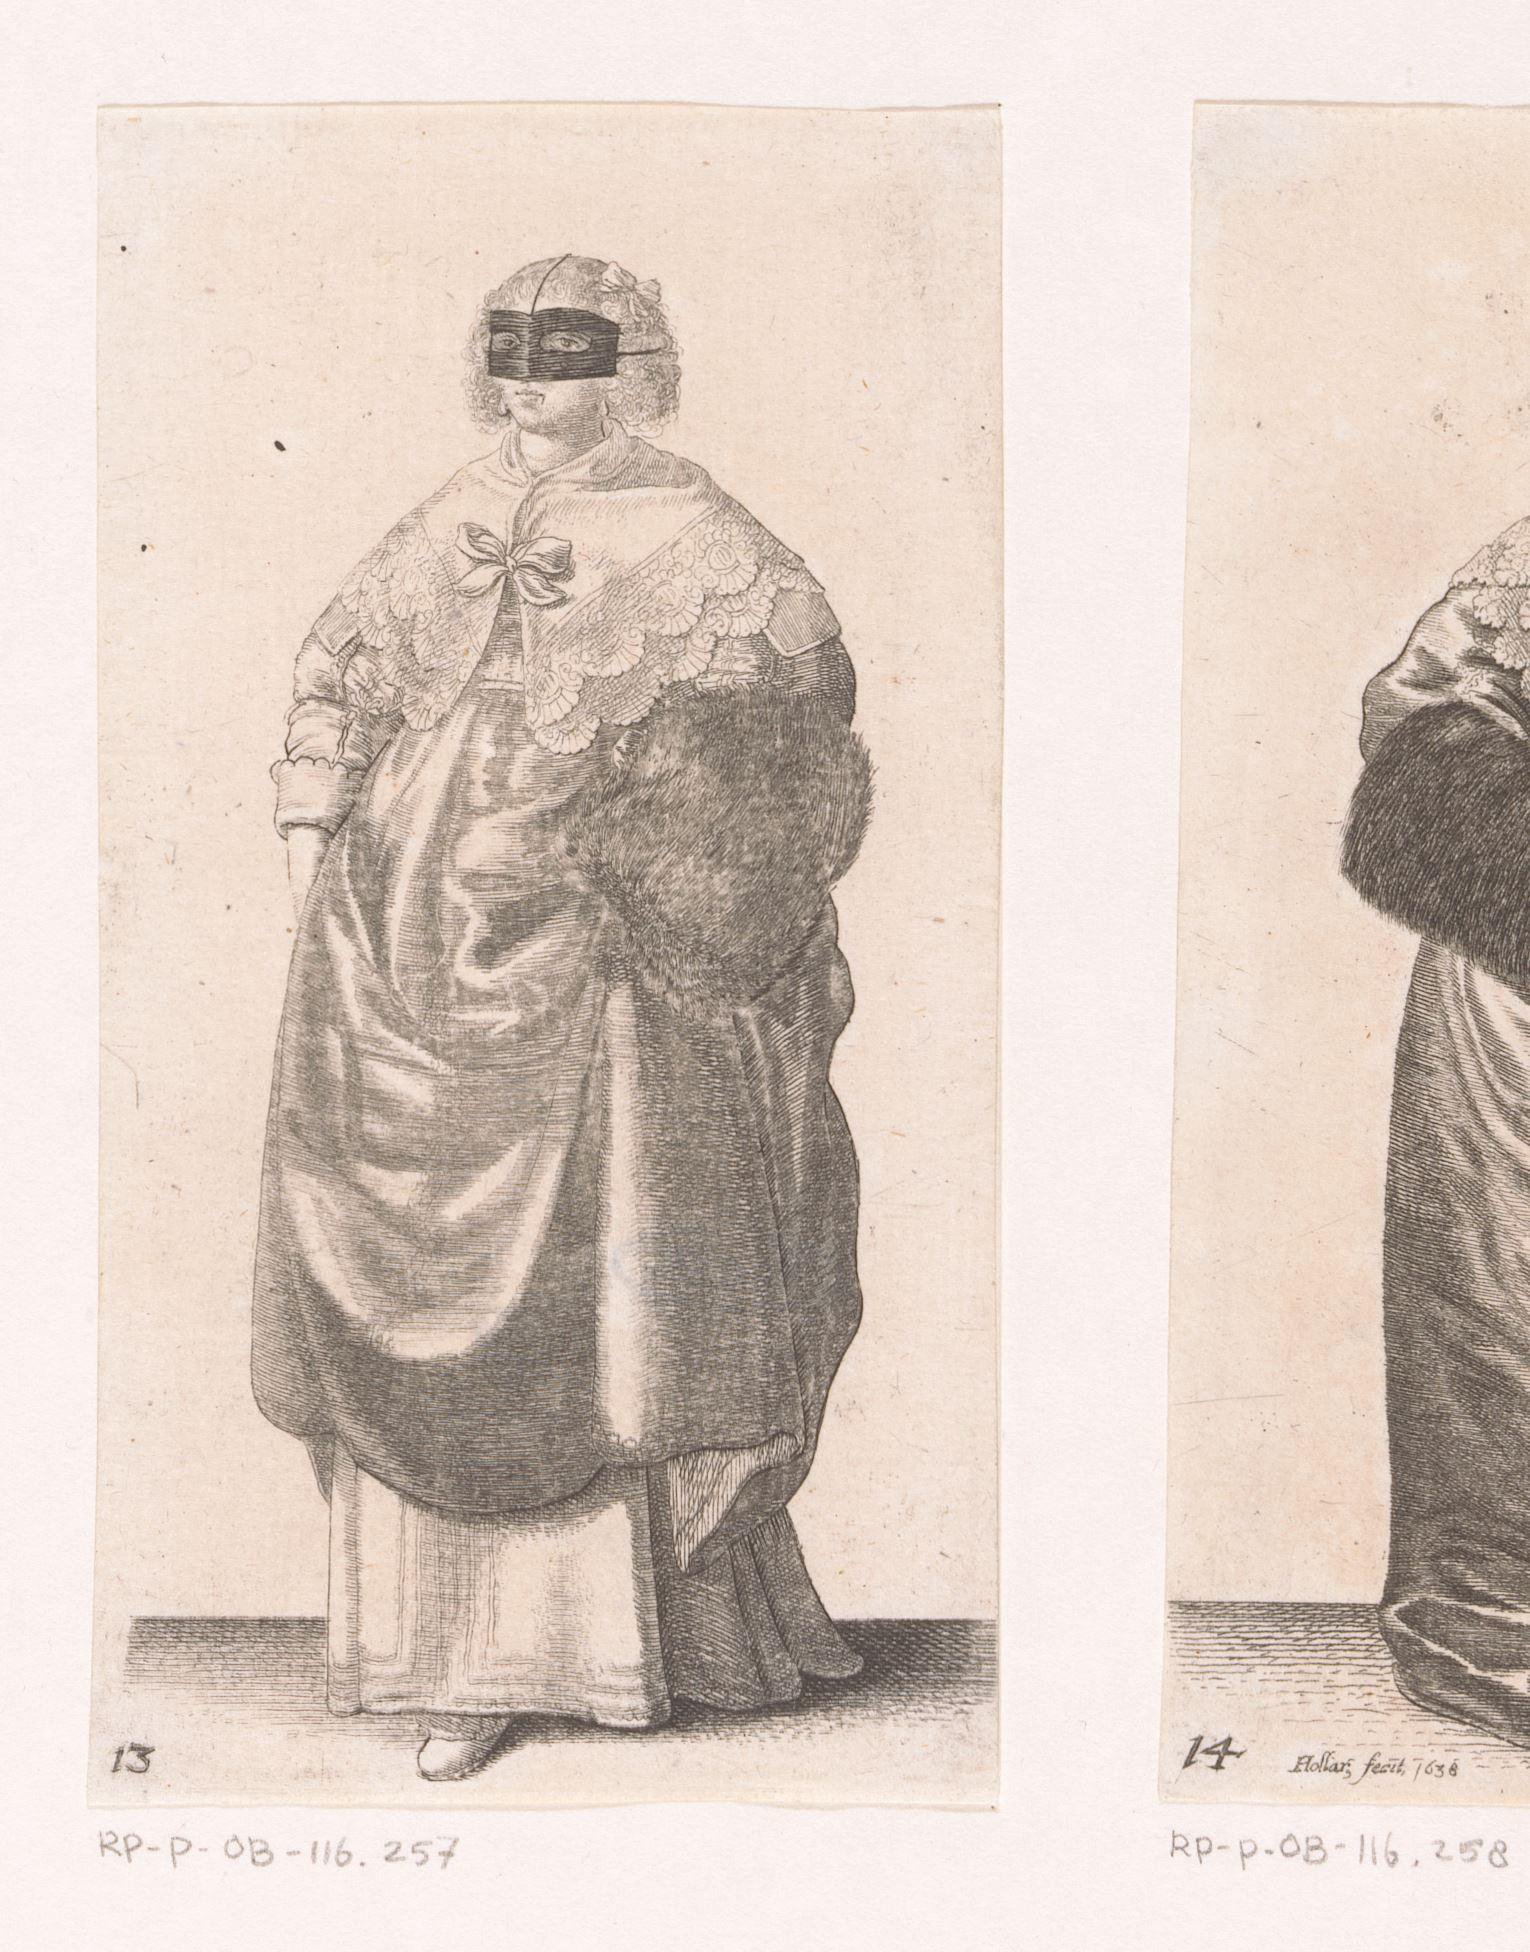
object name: costume print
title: Engelse vrouw van stand met maskertje voor het gezicht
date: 1638-1640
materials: paper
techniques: etching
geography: london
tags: mask (+ women's clothes), neck-gear ~ clothing (neckerchief) (+ women's clothes), muff, europeans: englishmen (+ women), styles of hairdress - aa - ~ women, fashion, clothing (+ lace used for clothes), neck-gear: collar (+ women's clothes), fashion plates, clothes, costume (+ women's clothes), piece of clothing covering the breast or décolleté (+ women's clothes), dress, gown (+ women's clothes)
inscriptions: collector's mark: Lugt 2760, collector's mark: Lugt 2228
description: Engelse vrouw van stand, een zwart stoffen maskertje voor het gezicht en een strik in haar haar. Een grote bontmof in de linkerhand. Het bovenkleed is iets opgenomen zodat de rand van het onderkleed zichtbaar is. Om de schouders een brede kraag, afgezet met kant, in het midden bijeengehouden door een grote strik.